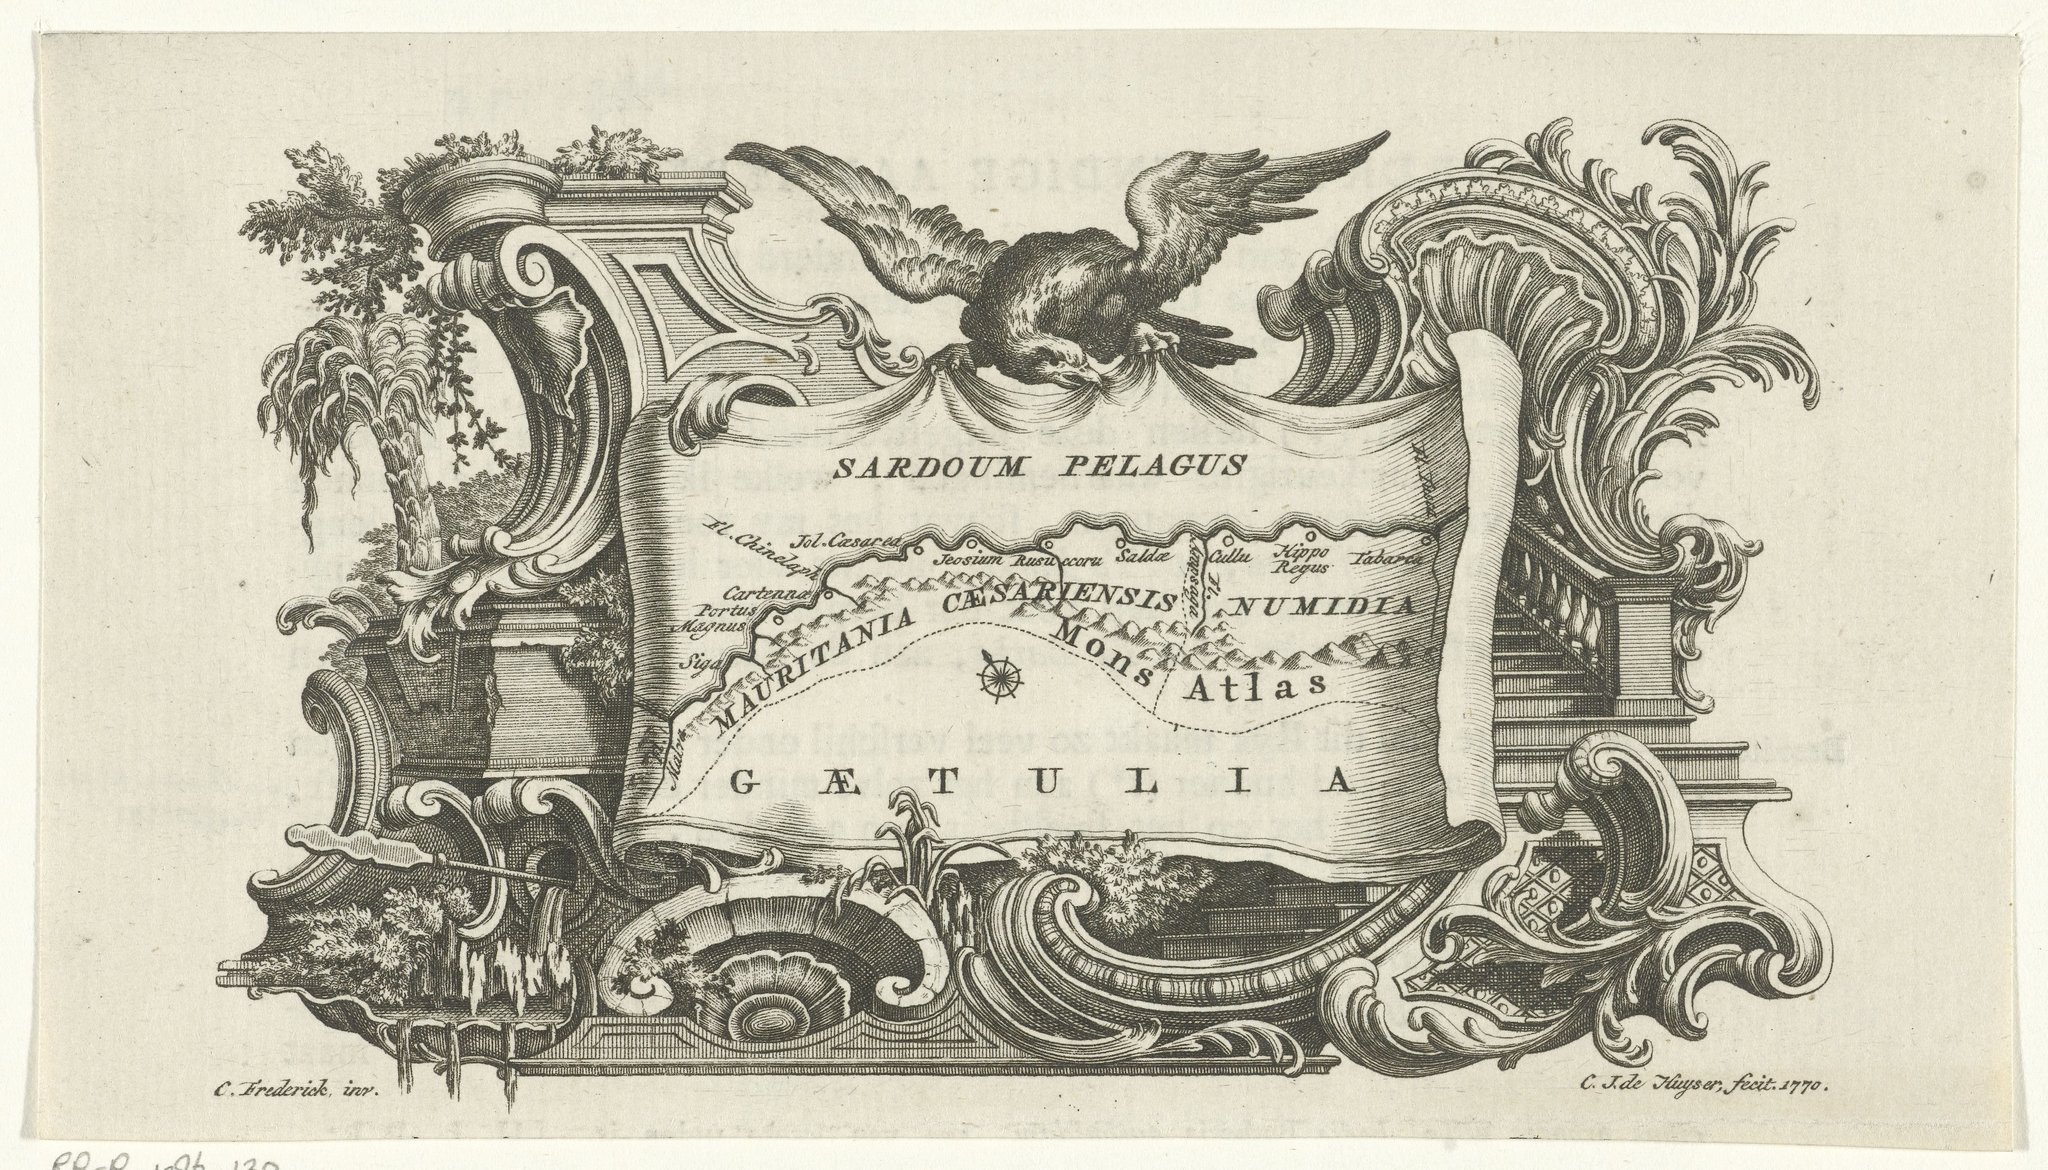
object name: book illustration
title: Kaart van de kust van Mauritanië en Zuid-Marokko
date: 1770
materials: paper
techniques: engraving, etching, letterpress printing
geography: amsterdam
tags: ornament derived from architectural details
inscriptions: collector's mark: Lugt 2228, collector's mark: Lugt 2760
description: Een kaart van de kust van Mauritanië en Zuid-Marokko, bovenaan vastgehouden door een adelaar. Om de kaart monumentale ornamenten.